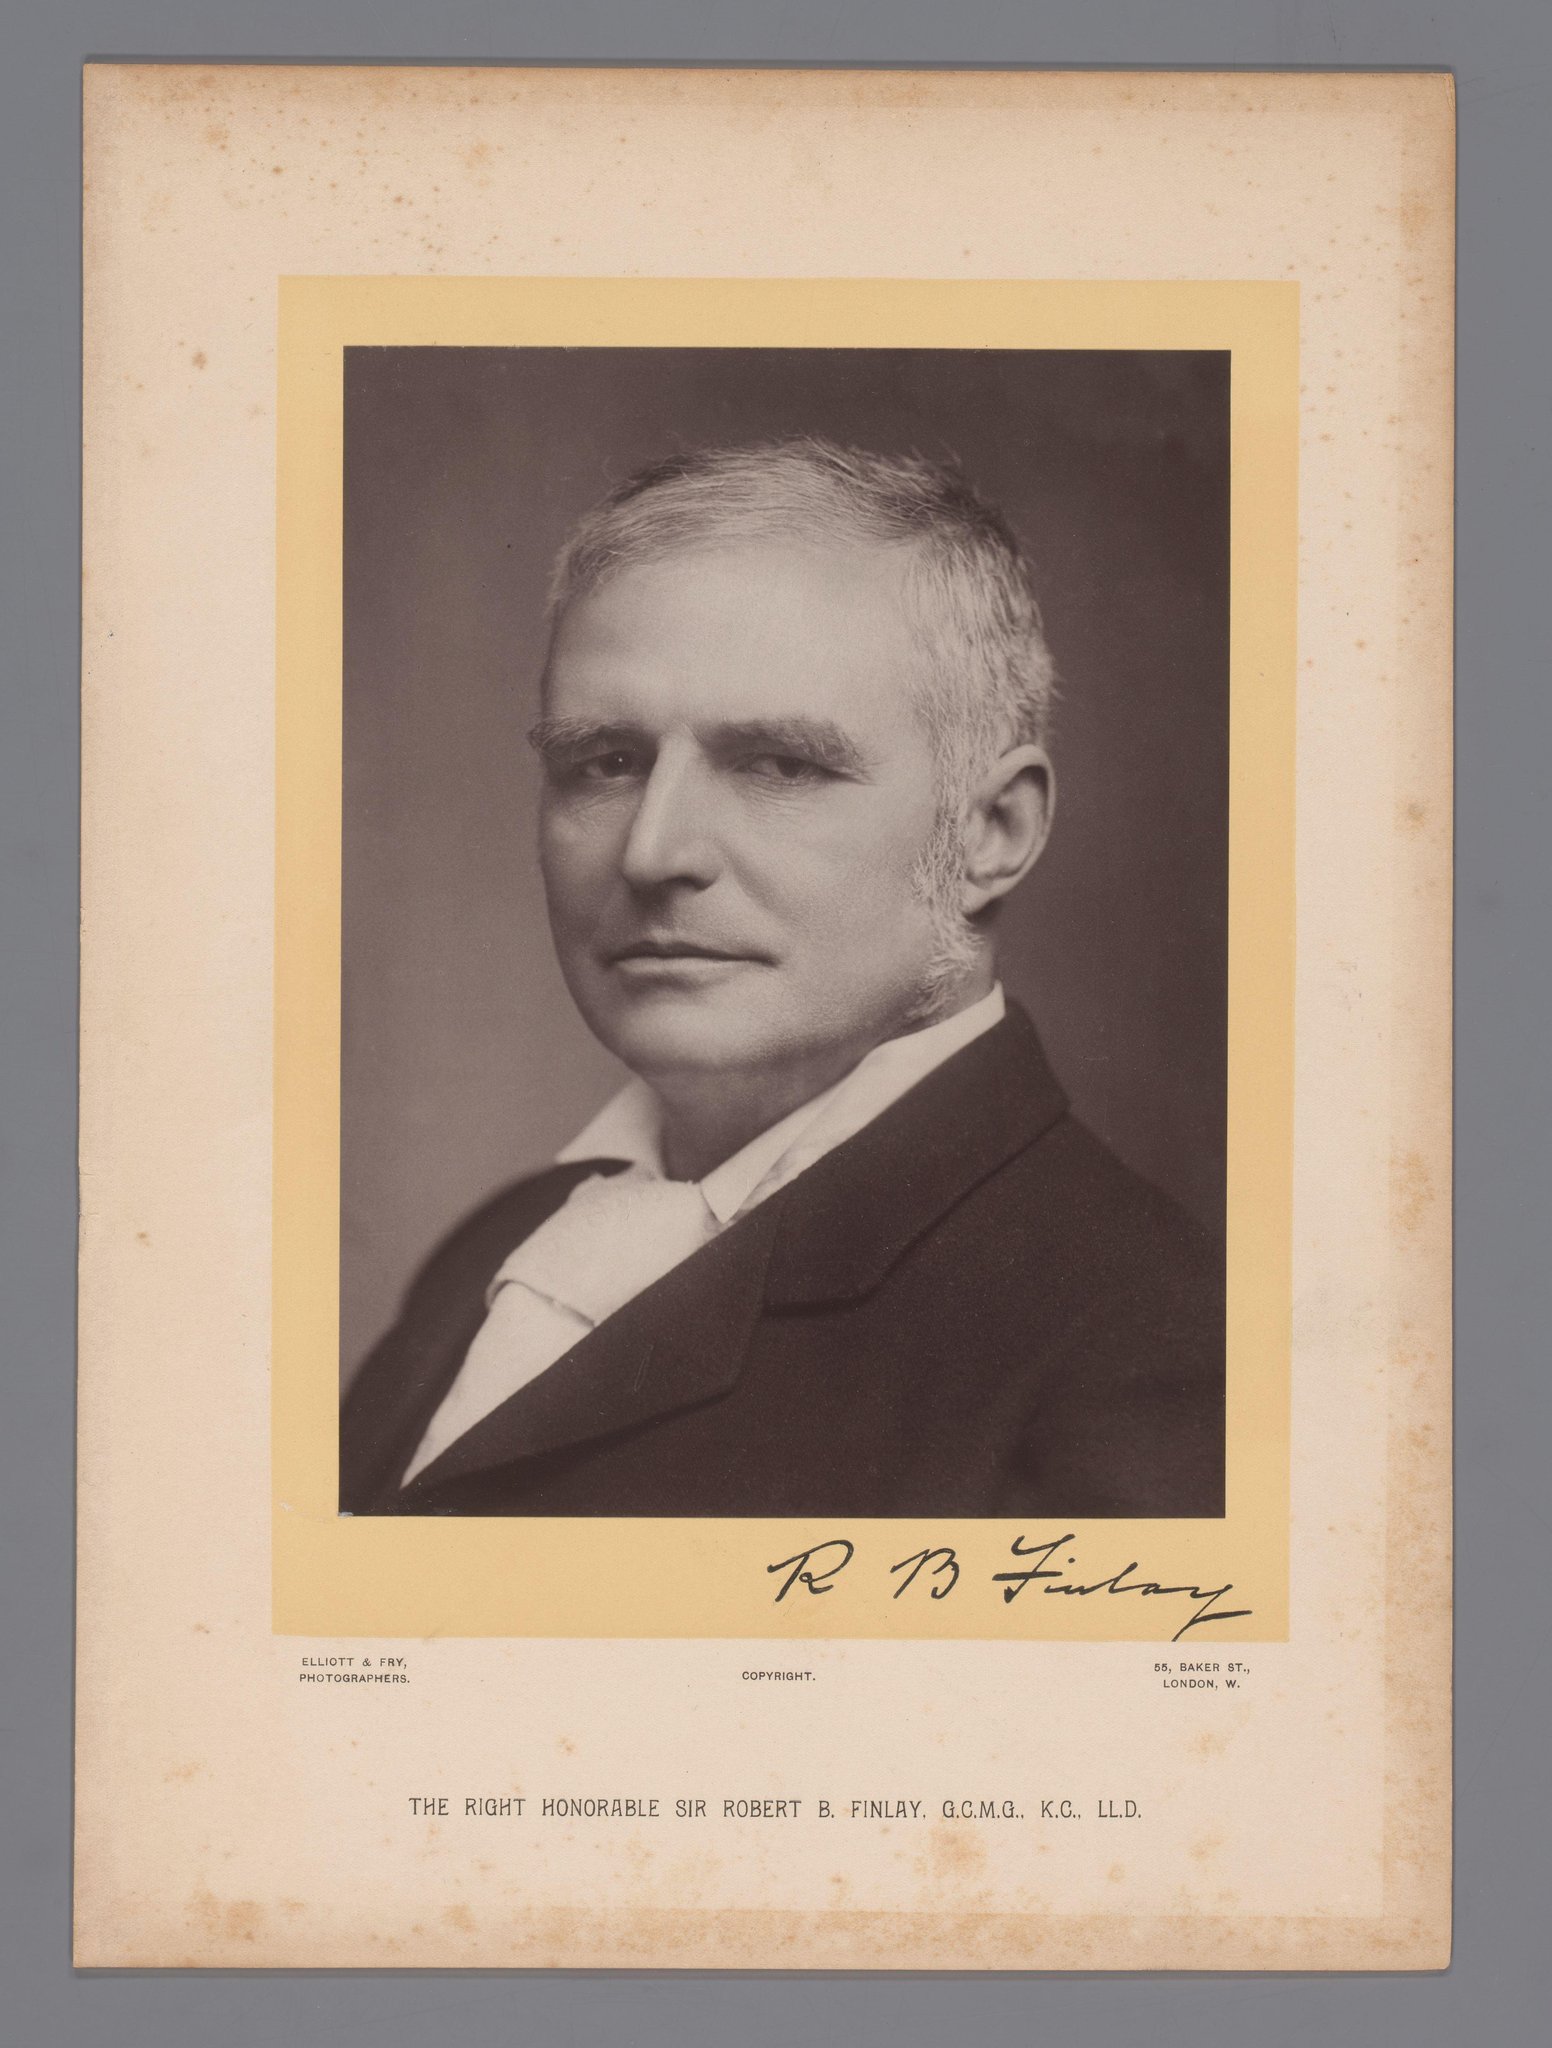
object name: photograph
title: The Right Honorable Sir Robert B. Finlay, G.C.M.G., K.C., L.L.D.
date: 1880-1910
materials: cardboard, paper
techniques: carbon print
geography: london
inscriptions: caption: ‘The Right Honorable Sir Robert B. Finlay, G.C.M.G., K.C., L.L.D.’, caption: ‘Elliott & Fry,//photographers//Copyright.//Baker St.//London, W.’, caption: ‘R B Finlay’